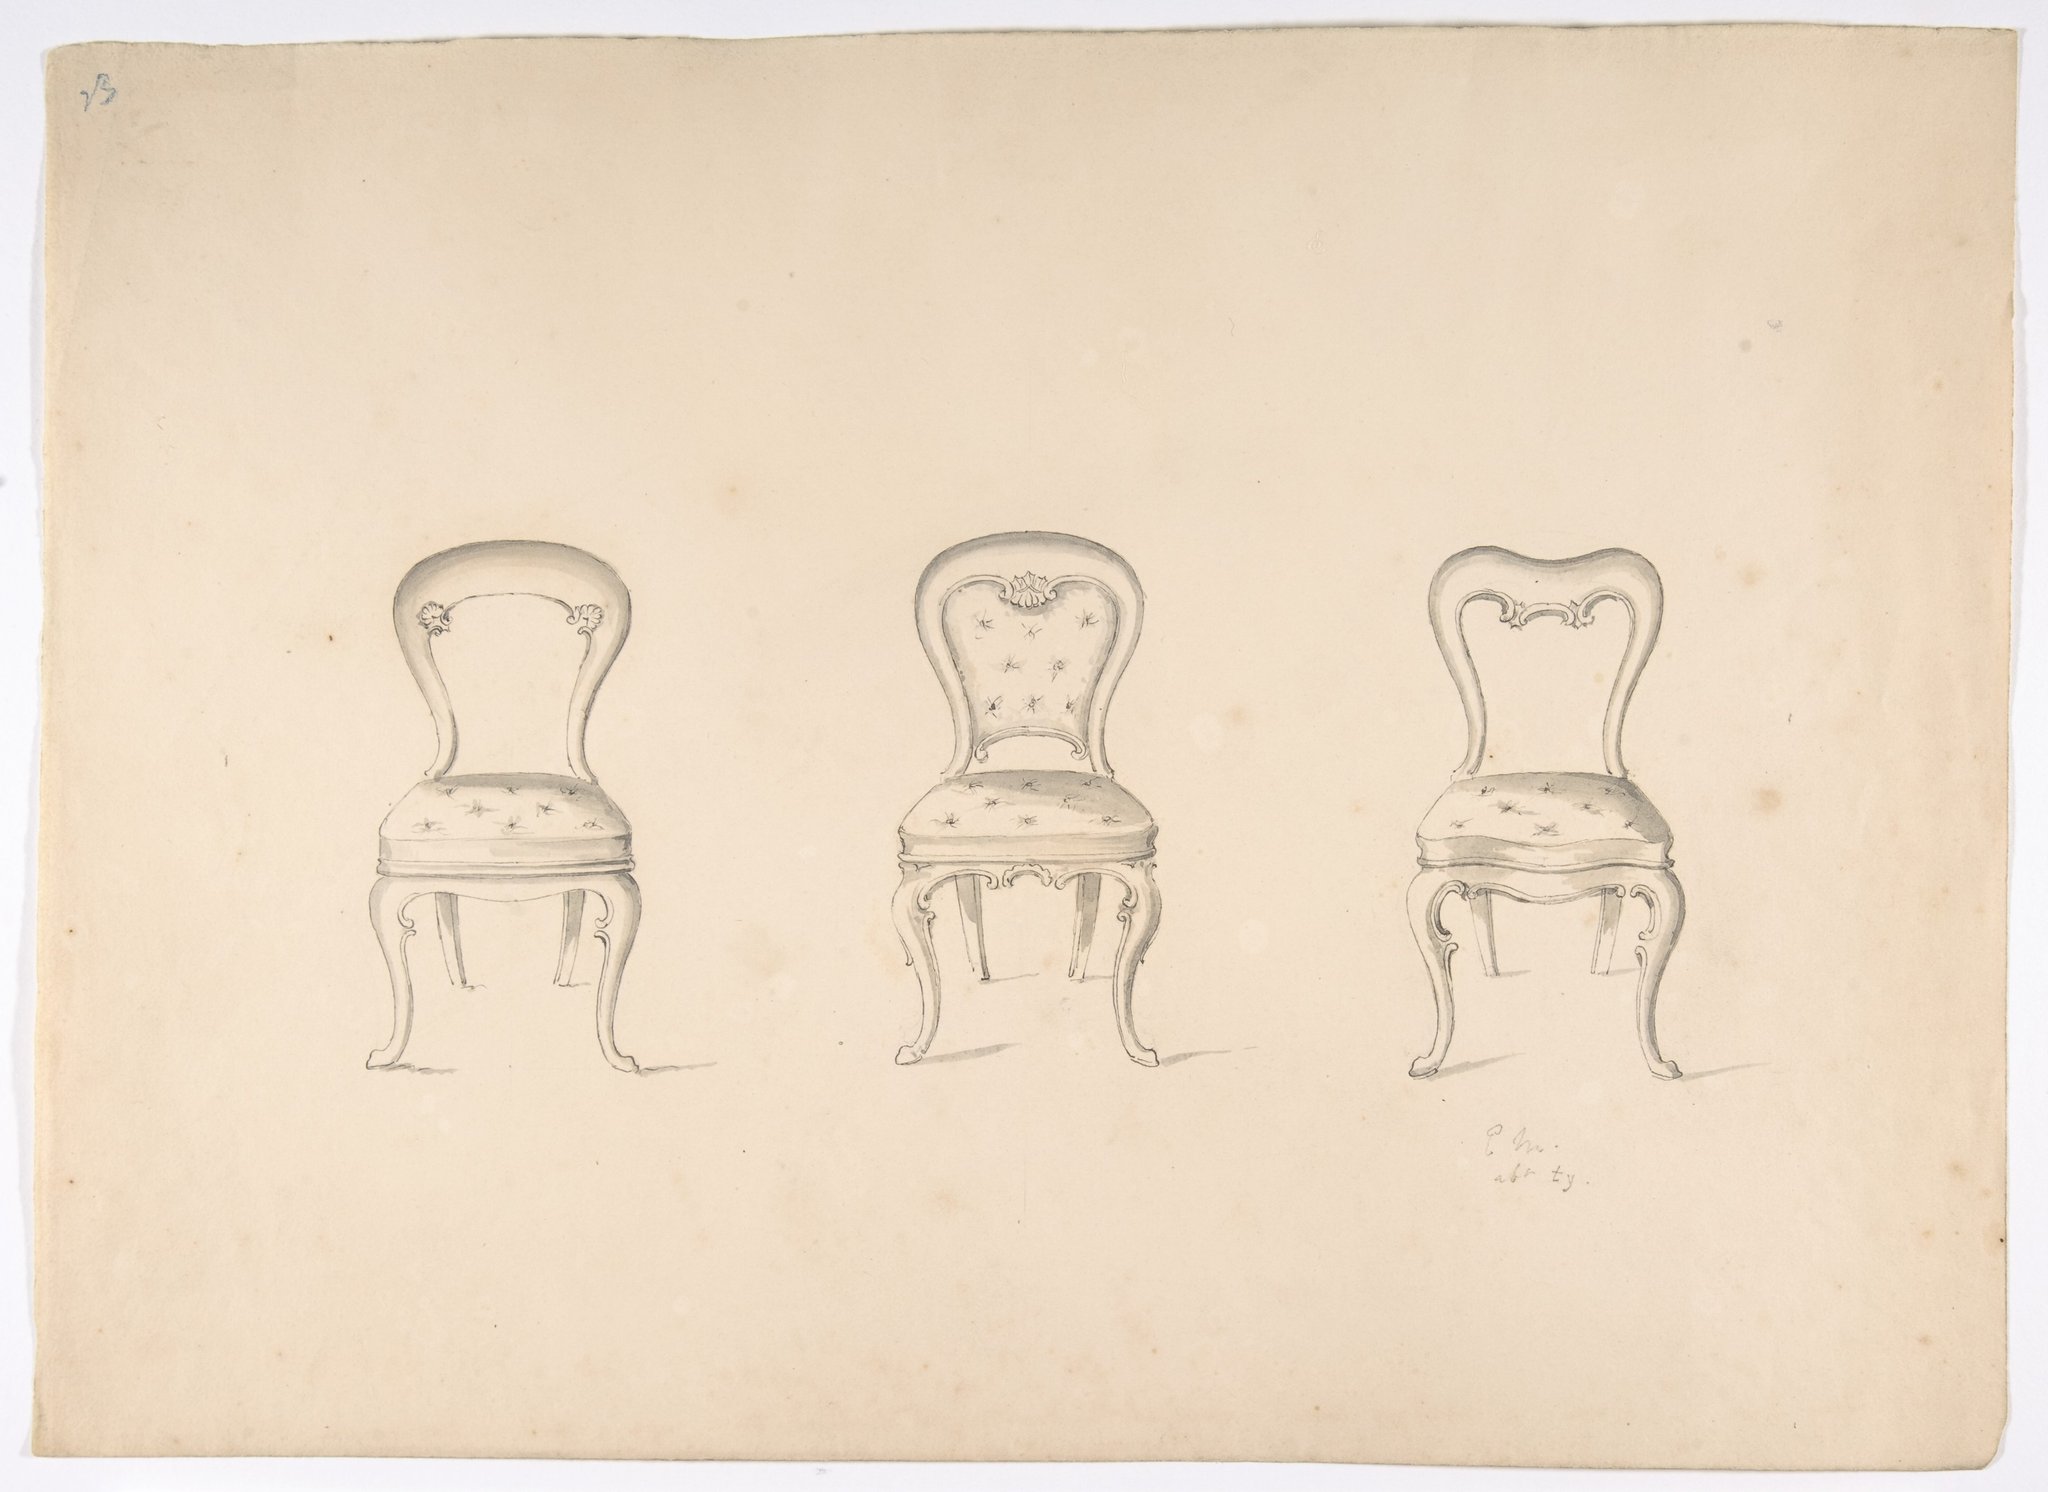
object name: drawing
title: Design for Three Chairs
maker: anonymous, british, 19th century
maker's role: artist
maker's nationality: british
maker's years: 1800-1900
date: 1801-1833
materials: graphite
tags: chairs